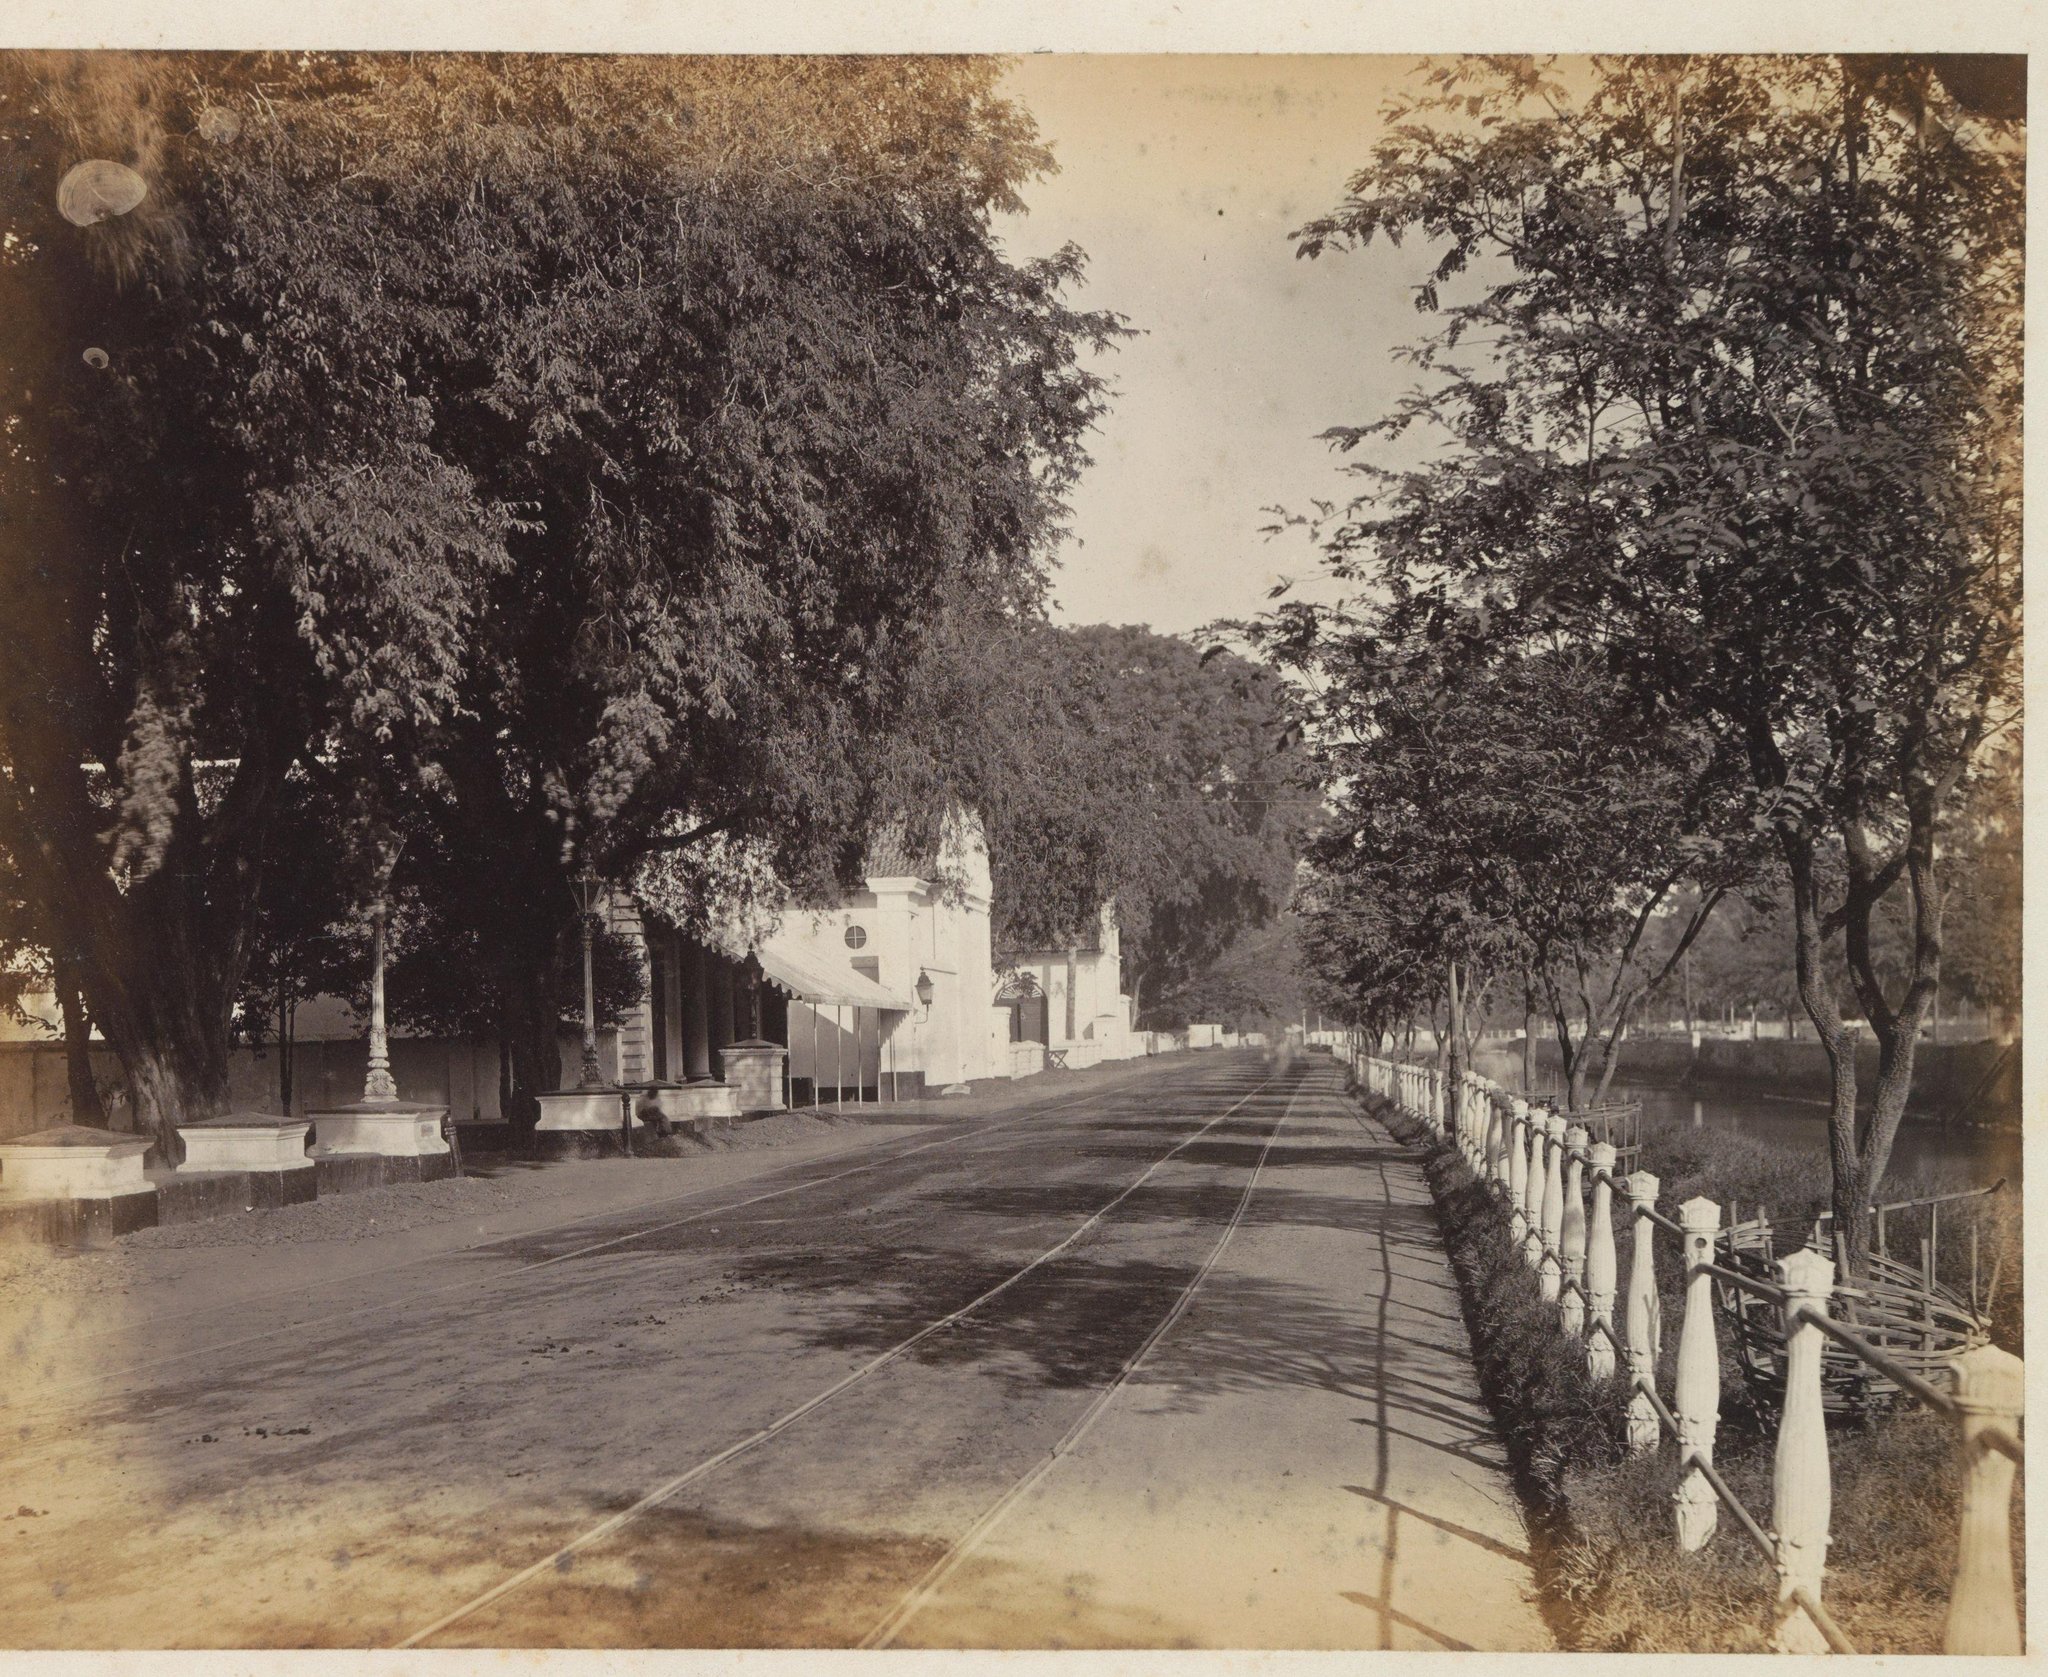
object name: photograph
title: Weg met tramrails op Java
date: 1857-1870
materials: photographic support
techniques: albumen print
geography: java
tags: railway, train, public road, java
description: Onderdeel van Fotoalbum met opnames van bezienswaardigheden op Java.